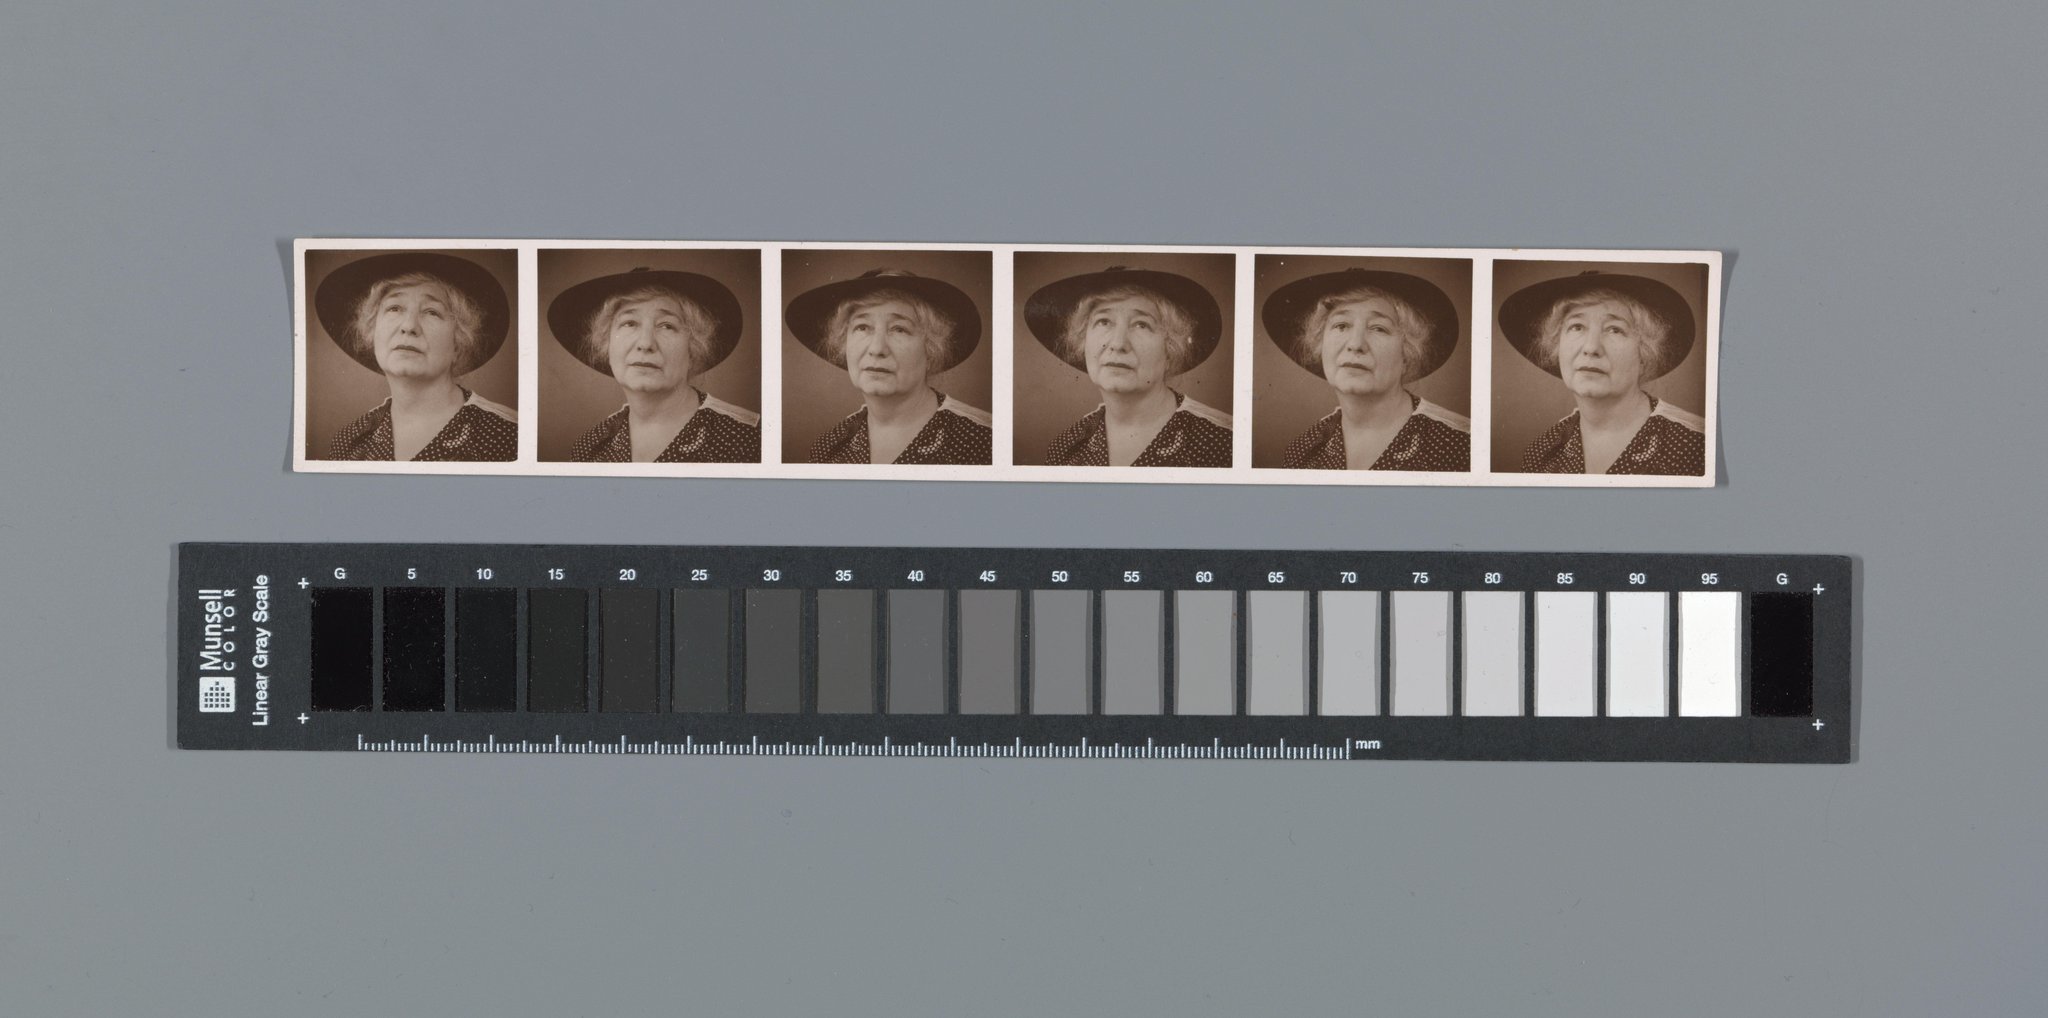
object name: passport photograph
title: Strook met 6 pasfoto's van Marie Witsen-Schorr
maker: Anonymous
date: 1860-1915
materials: paper, photographic support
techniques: gelatin silver print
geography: netherlands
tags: augusta maria agnes witsen-schorr